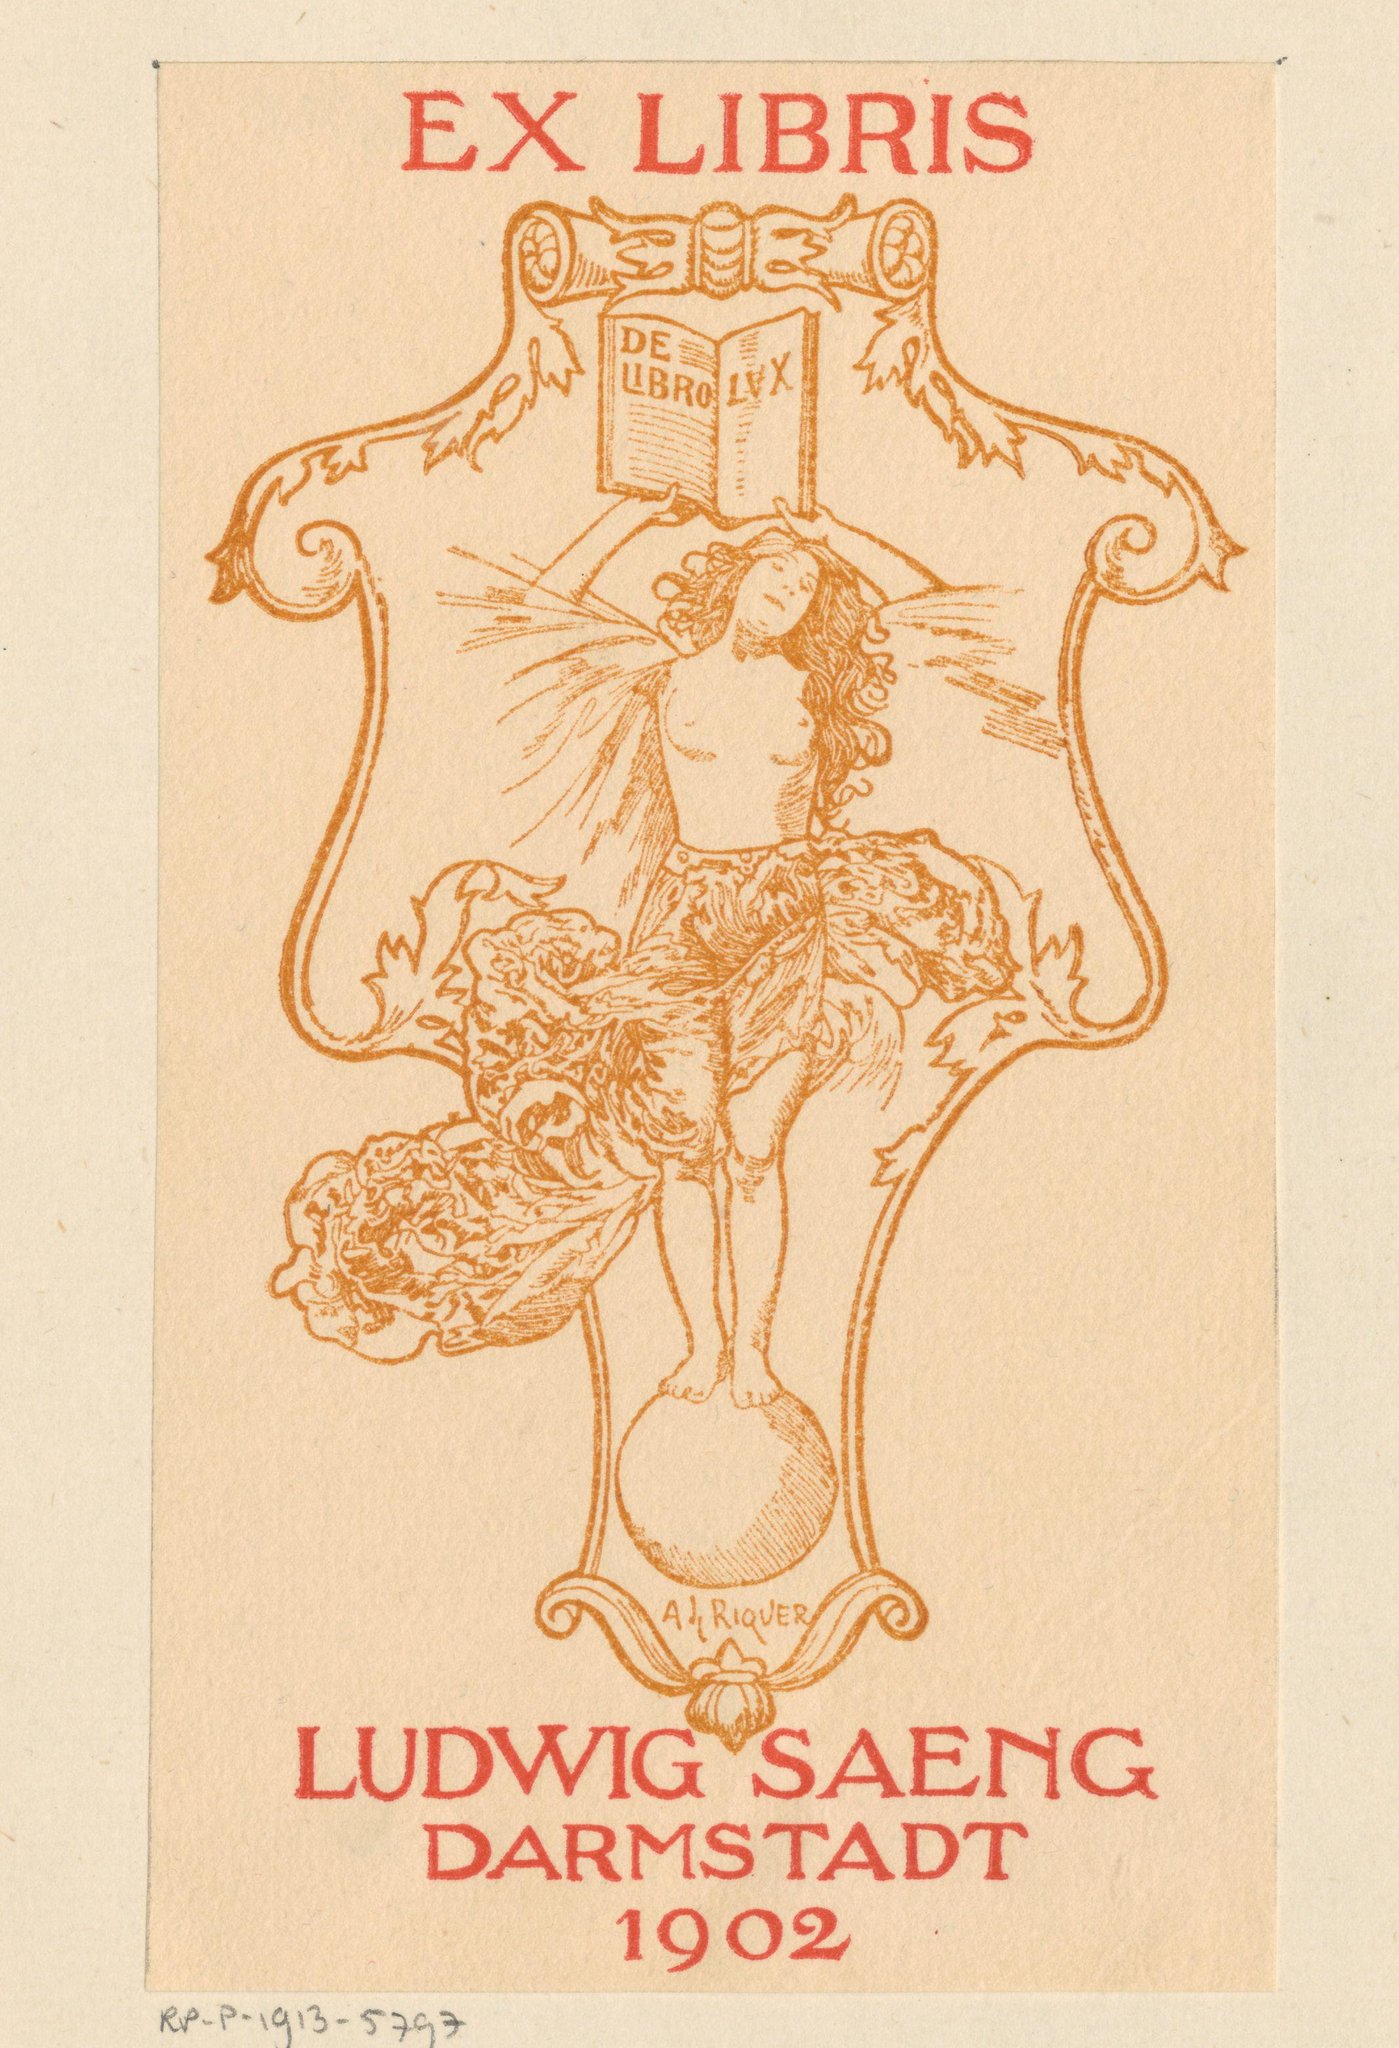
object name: bookplate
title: De libro lux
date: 1902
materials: paper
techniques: printing block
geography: spain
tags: politician, rocaille ornament, woman (showing herself) undressed, quasi-nude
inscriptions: collector's mark: Lugt 2233, collector's mark: Lugt 2760